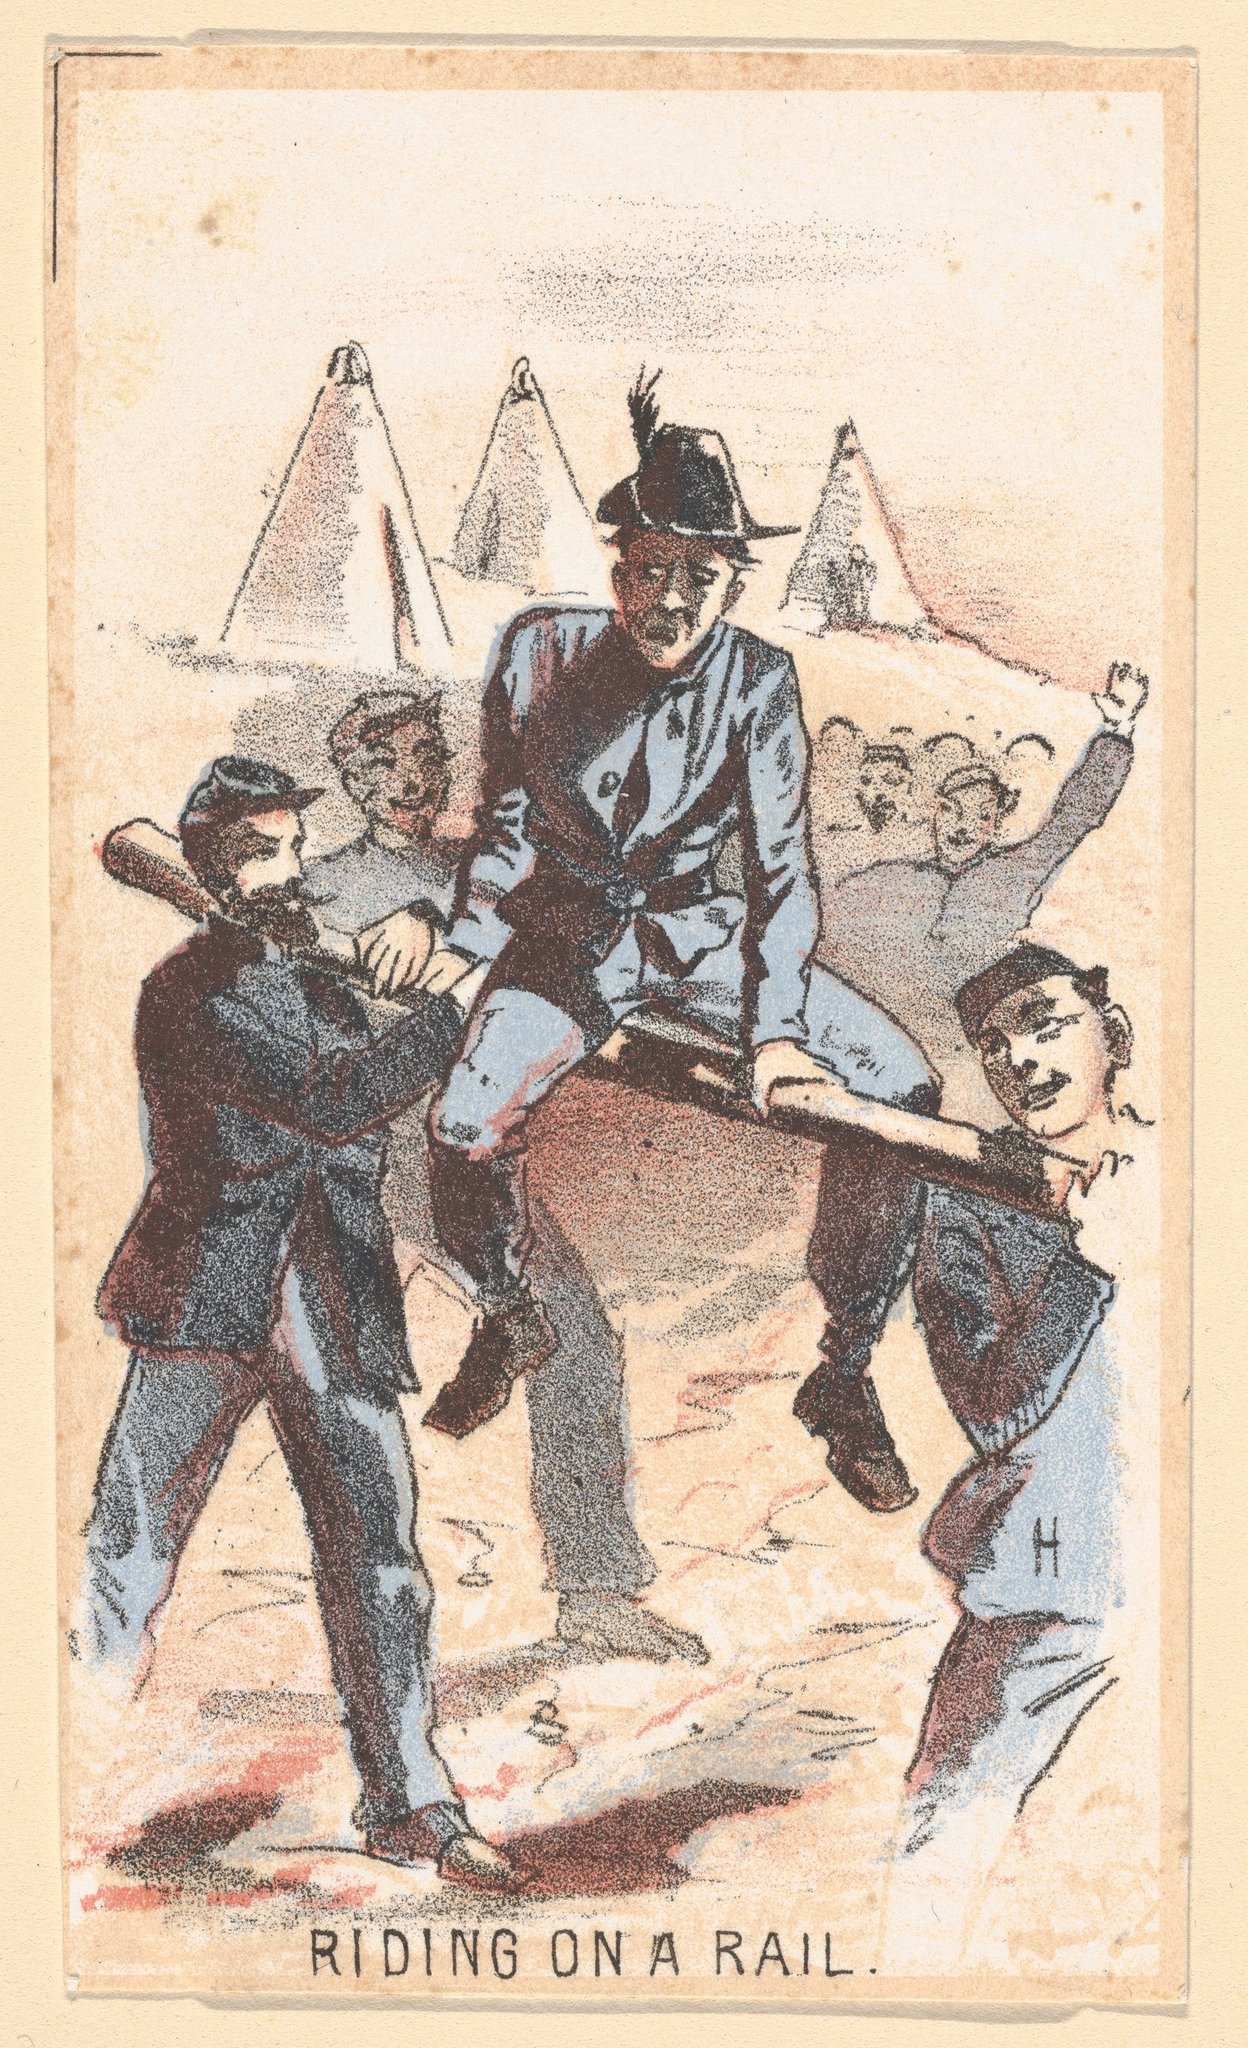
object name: print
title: Life in Camp, Part 1: Riding on a Rail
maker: winslow homer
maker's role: artist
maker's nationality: american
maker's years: 1836-1910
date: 1864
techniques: lithograph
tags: soldiers,american civil war,men